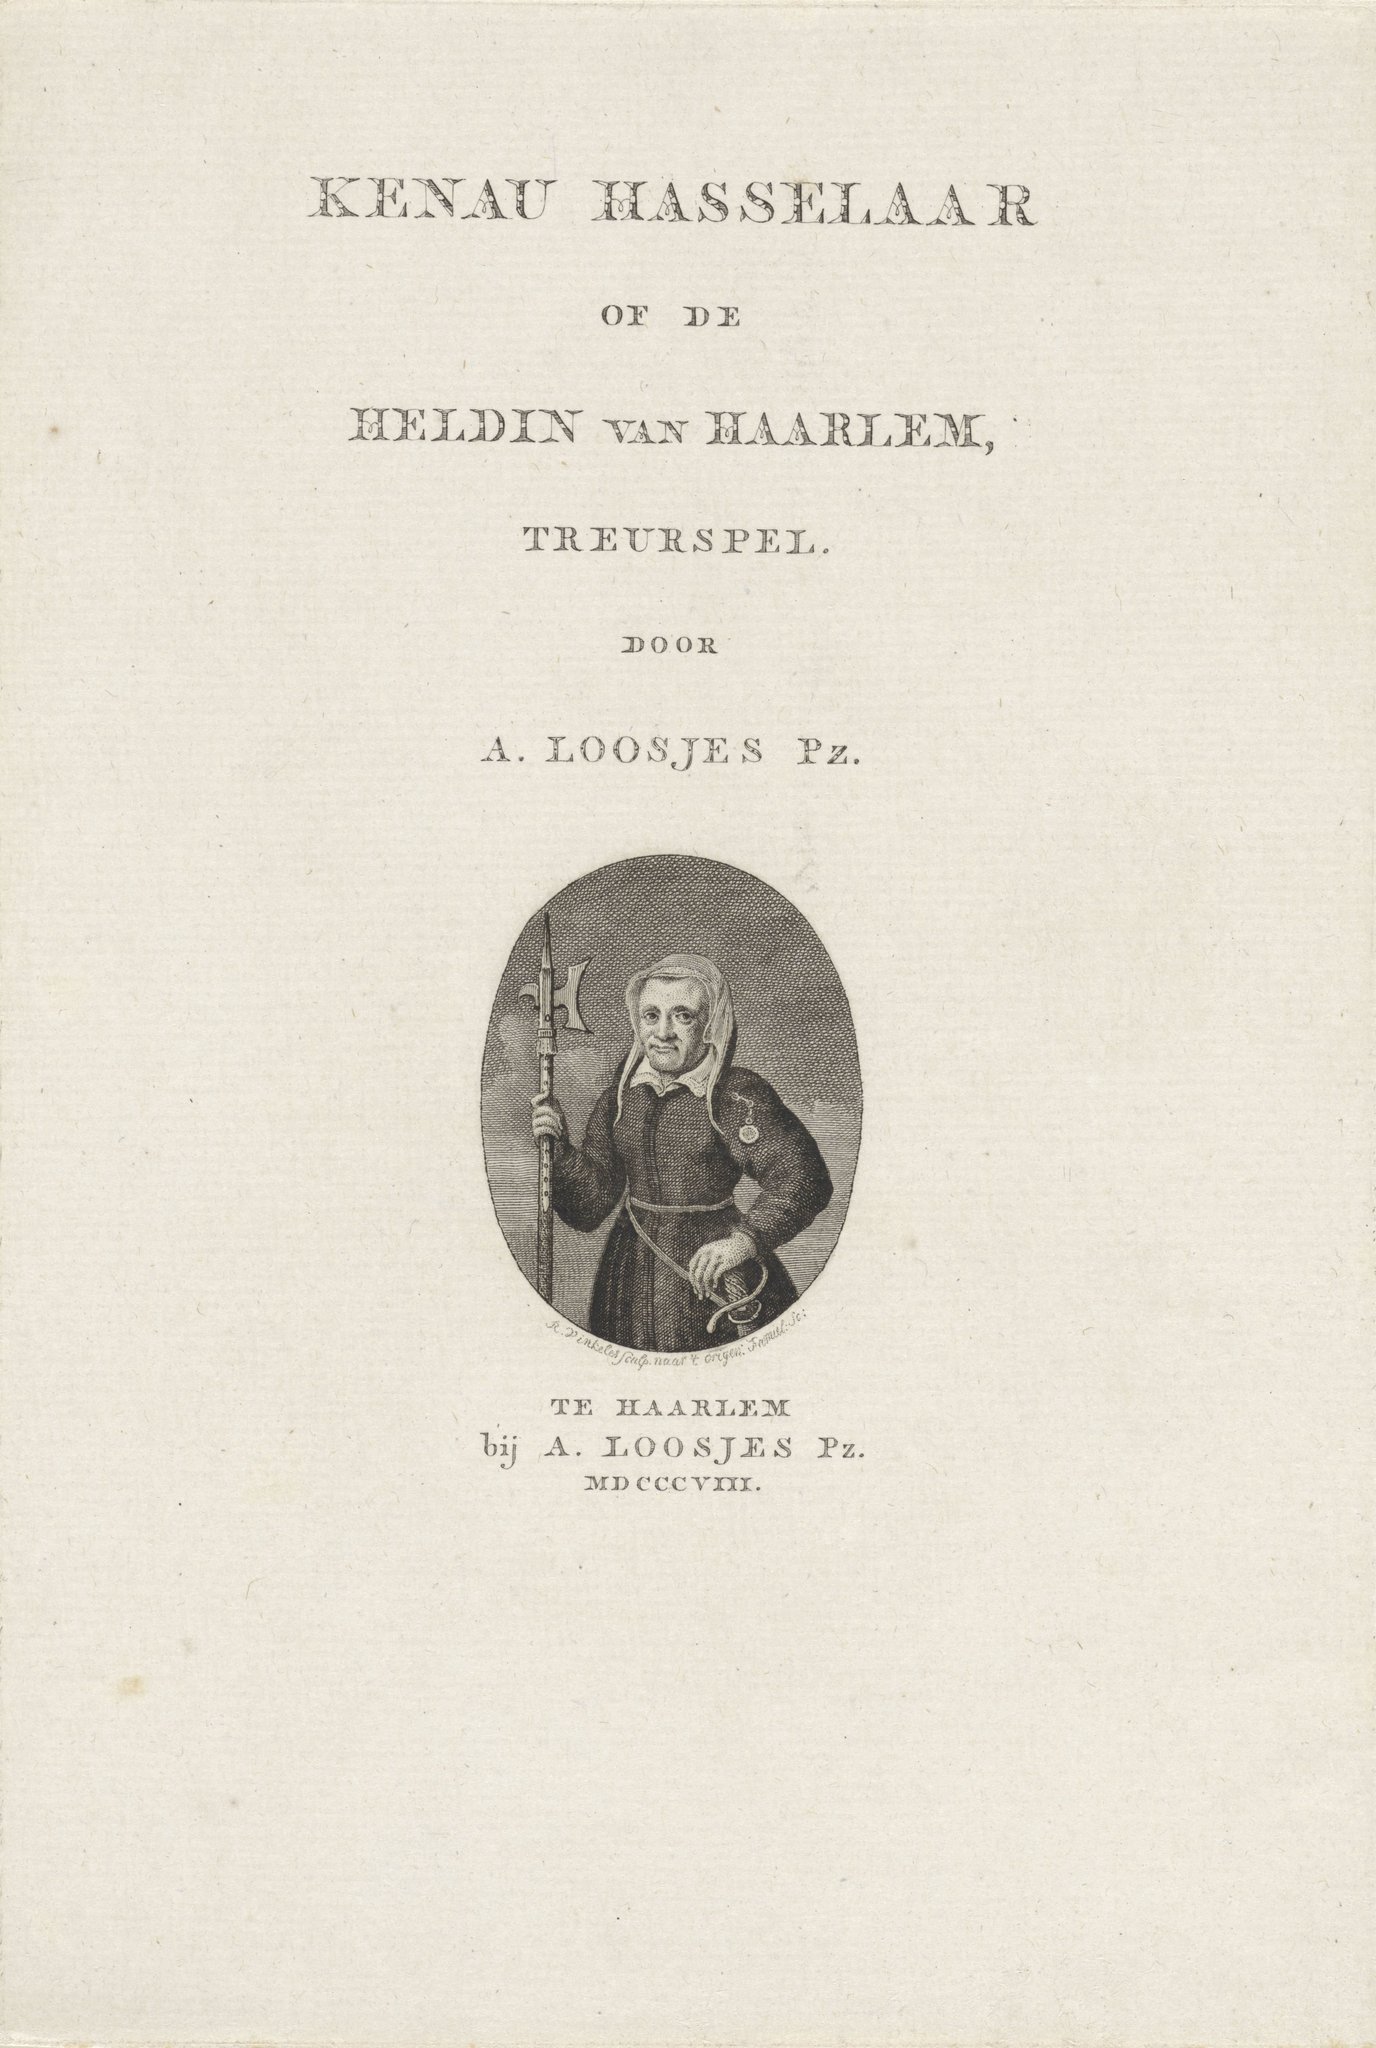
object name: titelprent, frontispice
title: Titelprent `Kenau Hasselaar of de Heldin van Haarlem, treurspel', door A. Loosjes Pz., 1808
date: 1808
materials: paper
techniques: engraving, etching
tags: haarlem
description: Titelpagina voor: Loosjes, Pz. Adriaan. Kenau Hasselaar: of de Heldin van Haarlem : treurspel. Haarlem: Adriaan Loosjes Pz., 1808.